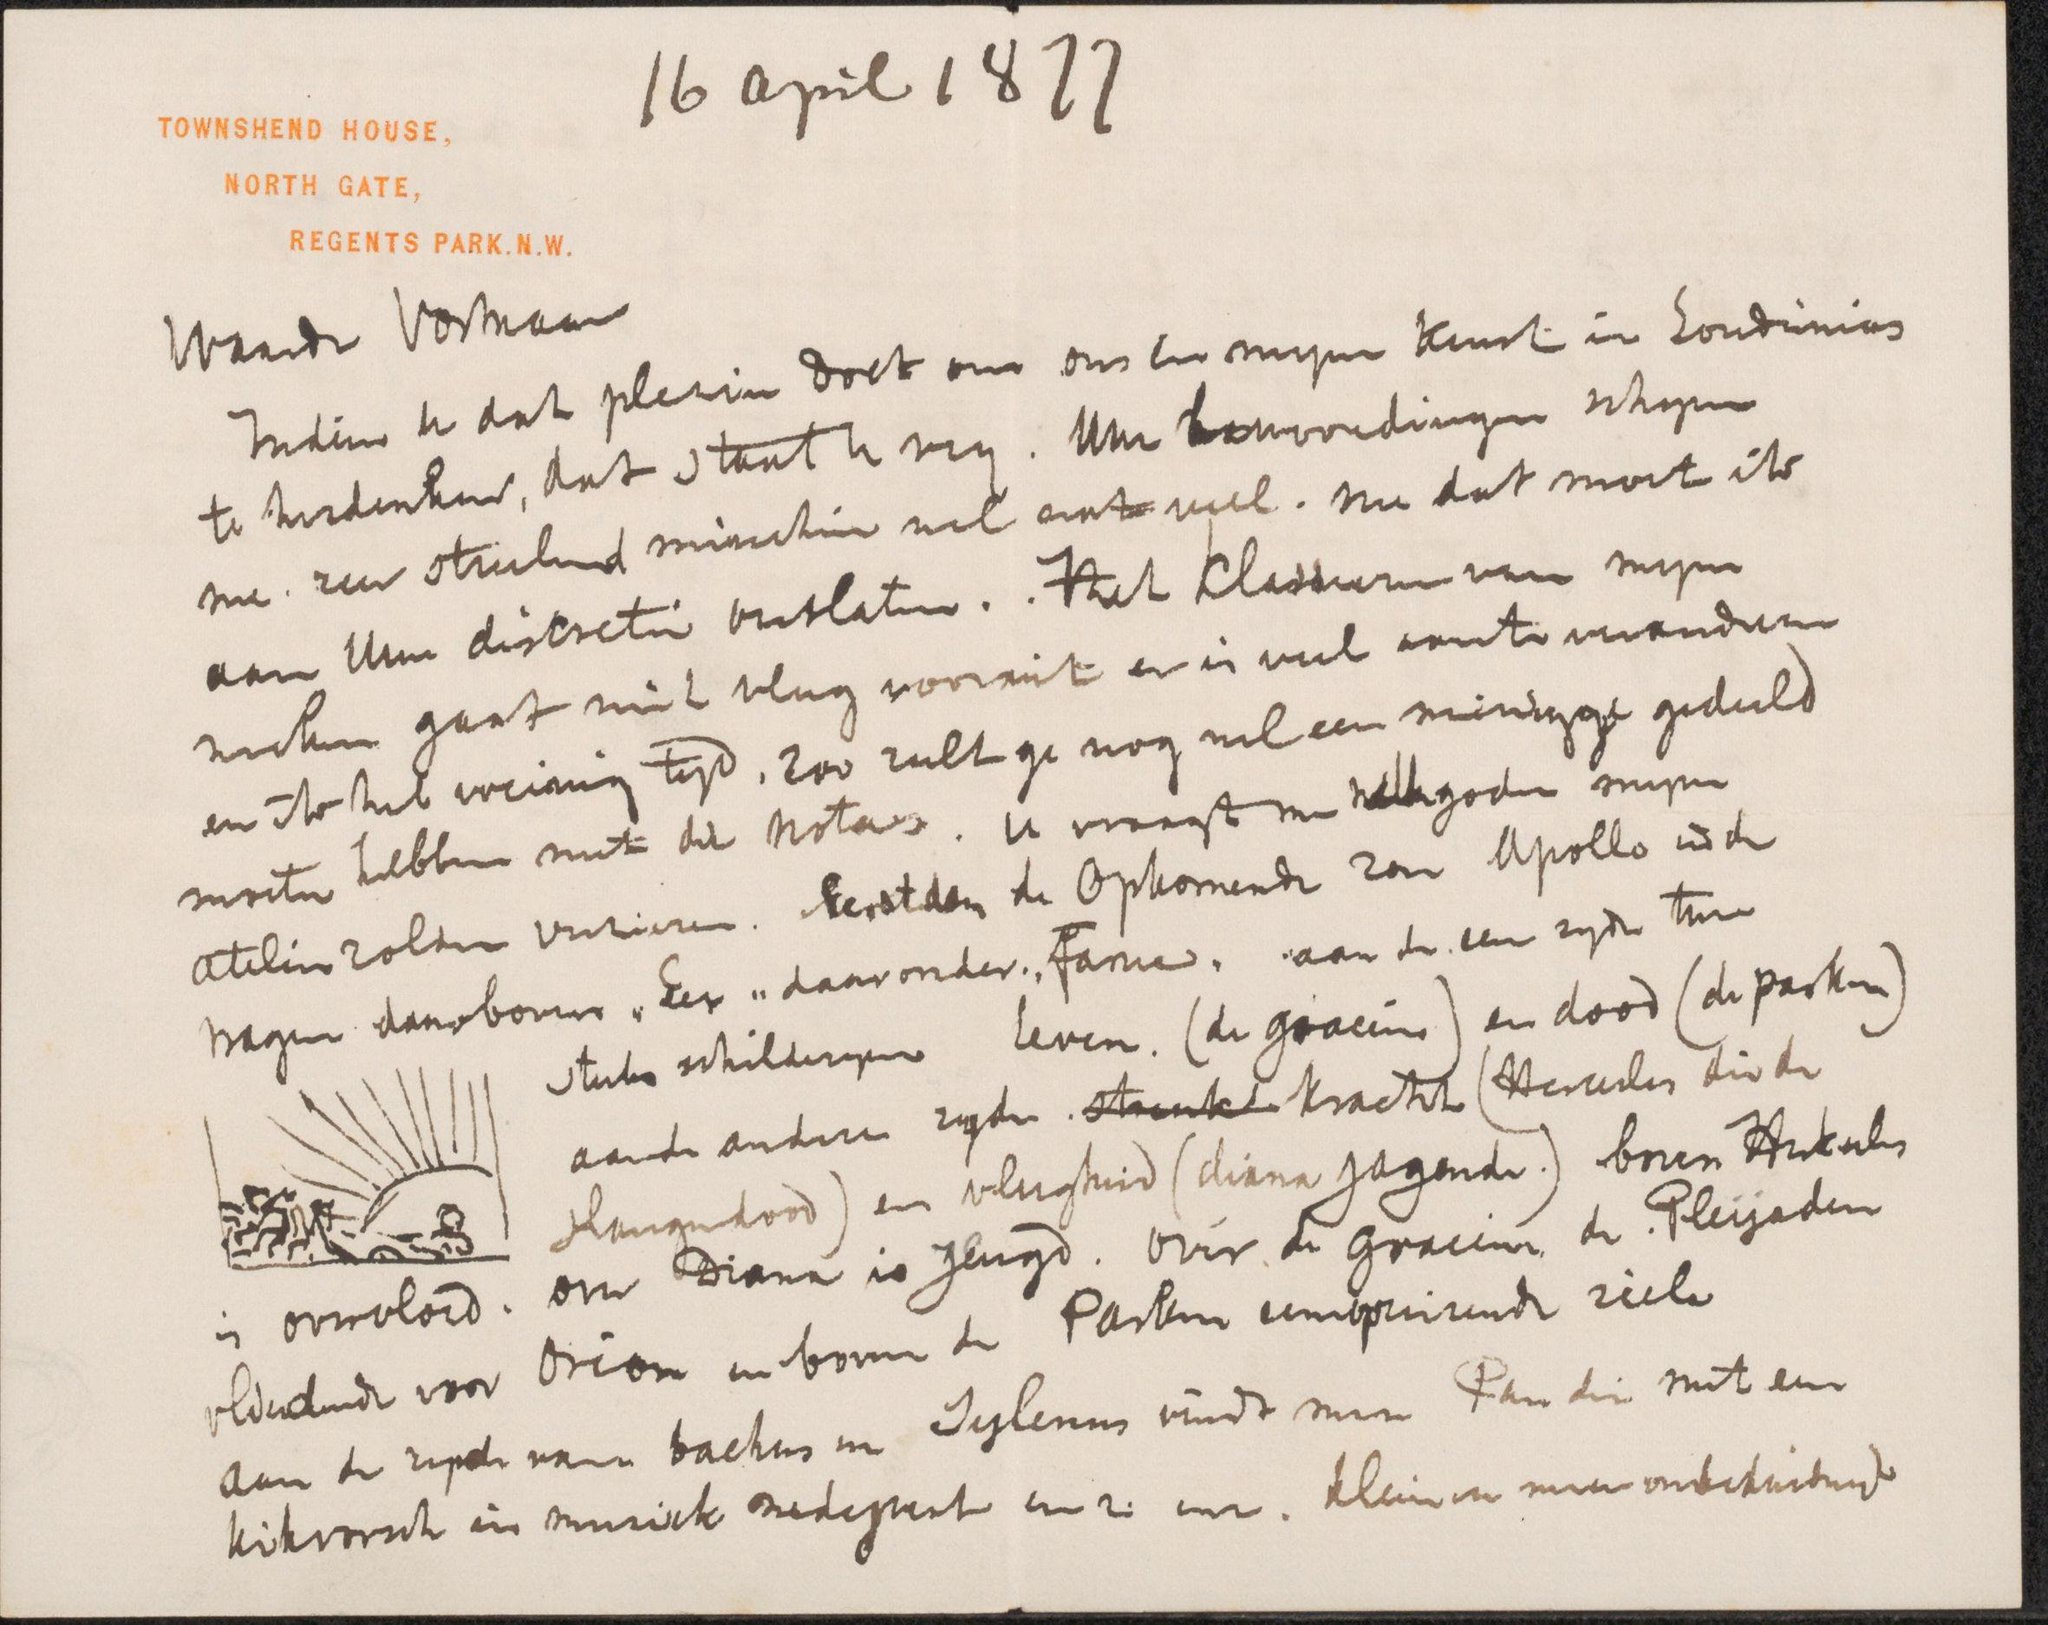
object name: letter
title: Brief aan Carel Vosmaer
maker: lourens alma tadema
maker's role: draughtsman, print maker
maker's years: 1836-1912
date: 1877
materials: ink, paper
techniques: pen, printing, writing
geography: london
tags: the hague, print maker, draughtsman, carel vosmaer, painting (including book-illumination, miniature-painting)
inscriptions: watermark